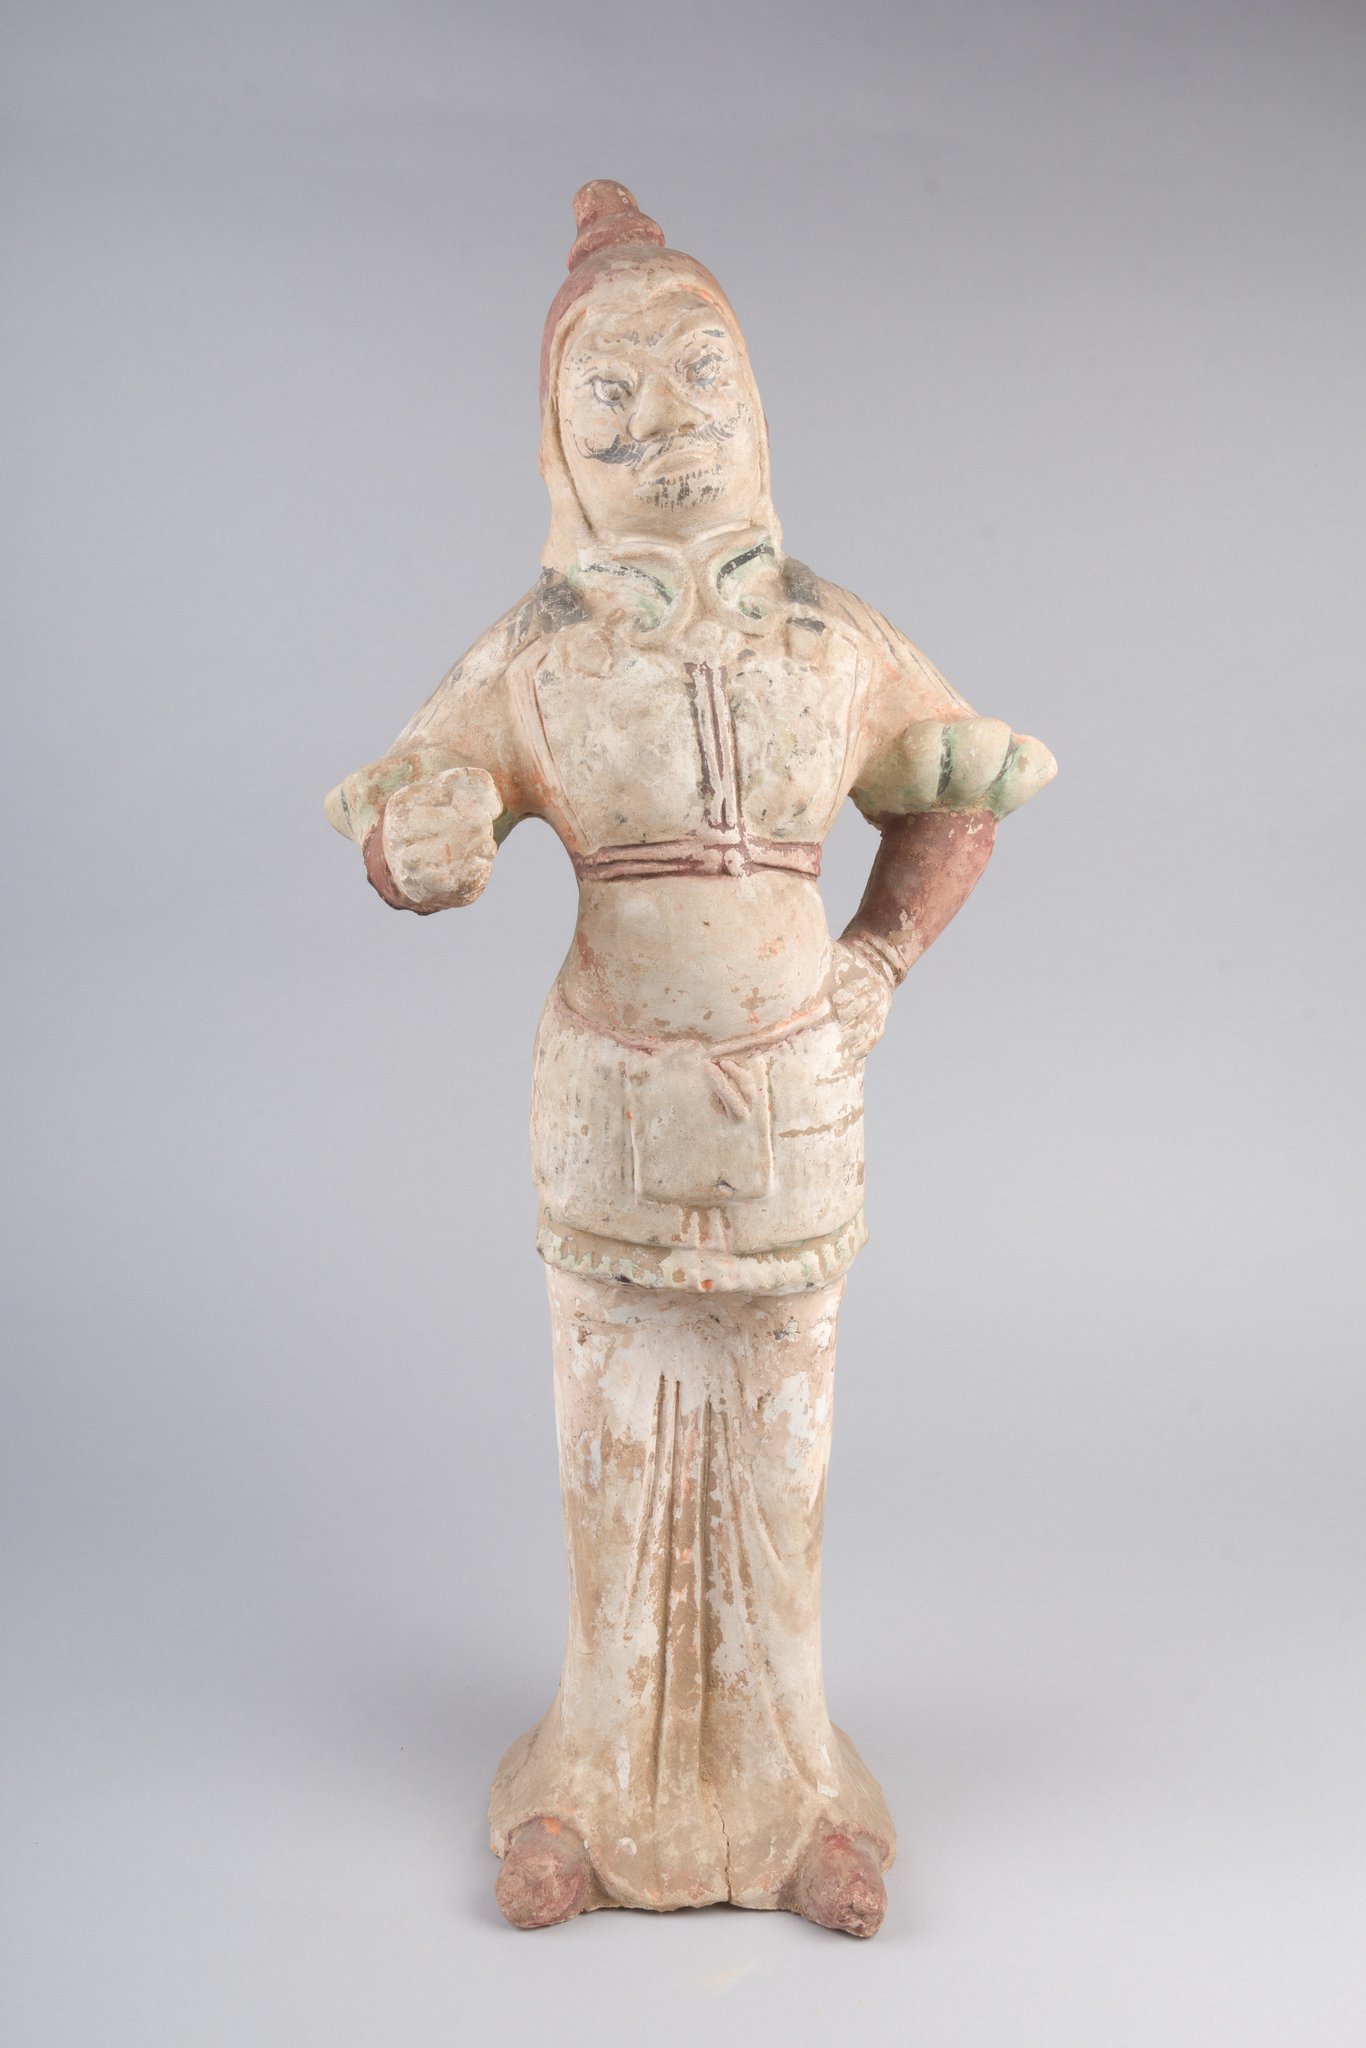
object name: figure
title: Warrior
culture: chinese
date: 601-800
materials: earthenware, pigment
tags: men,warriors